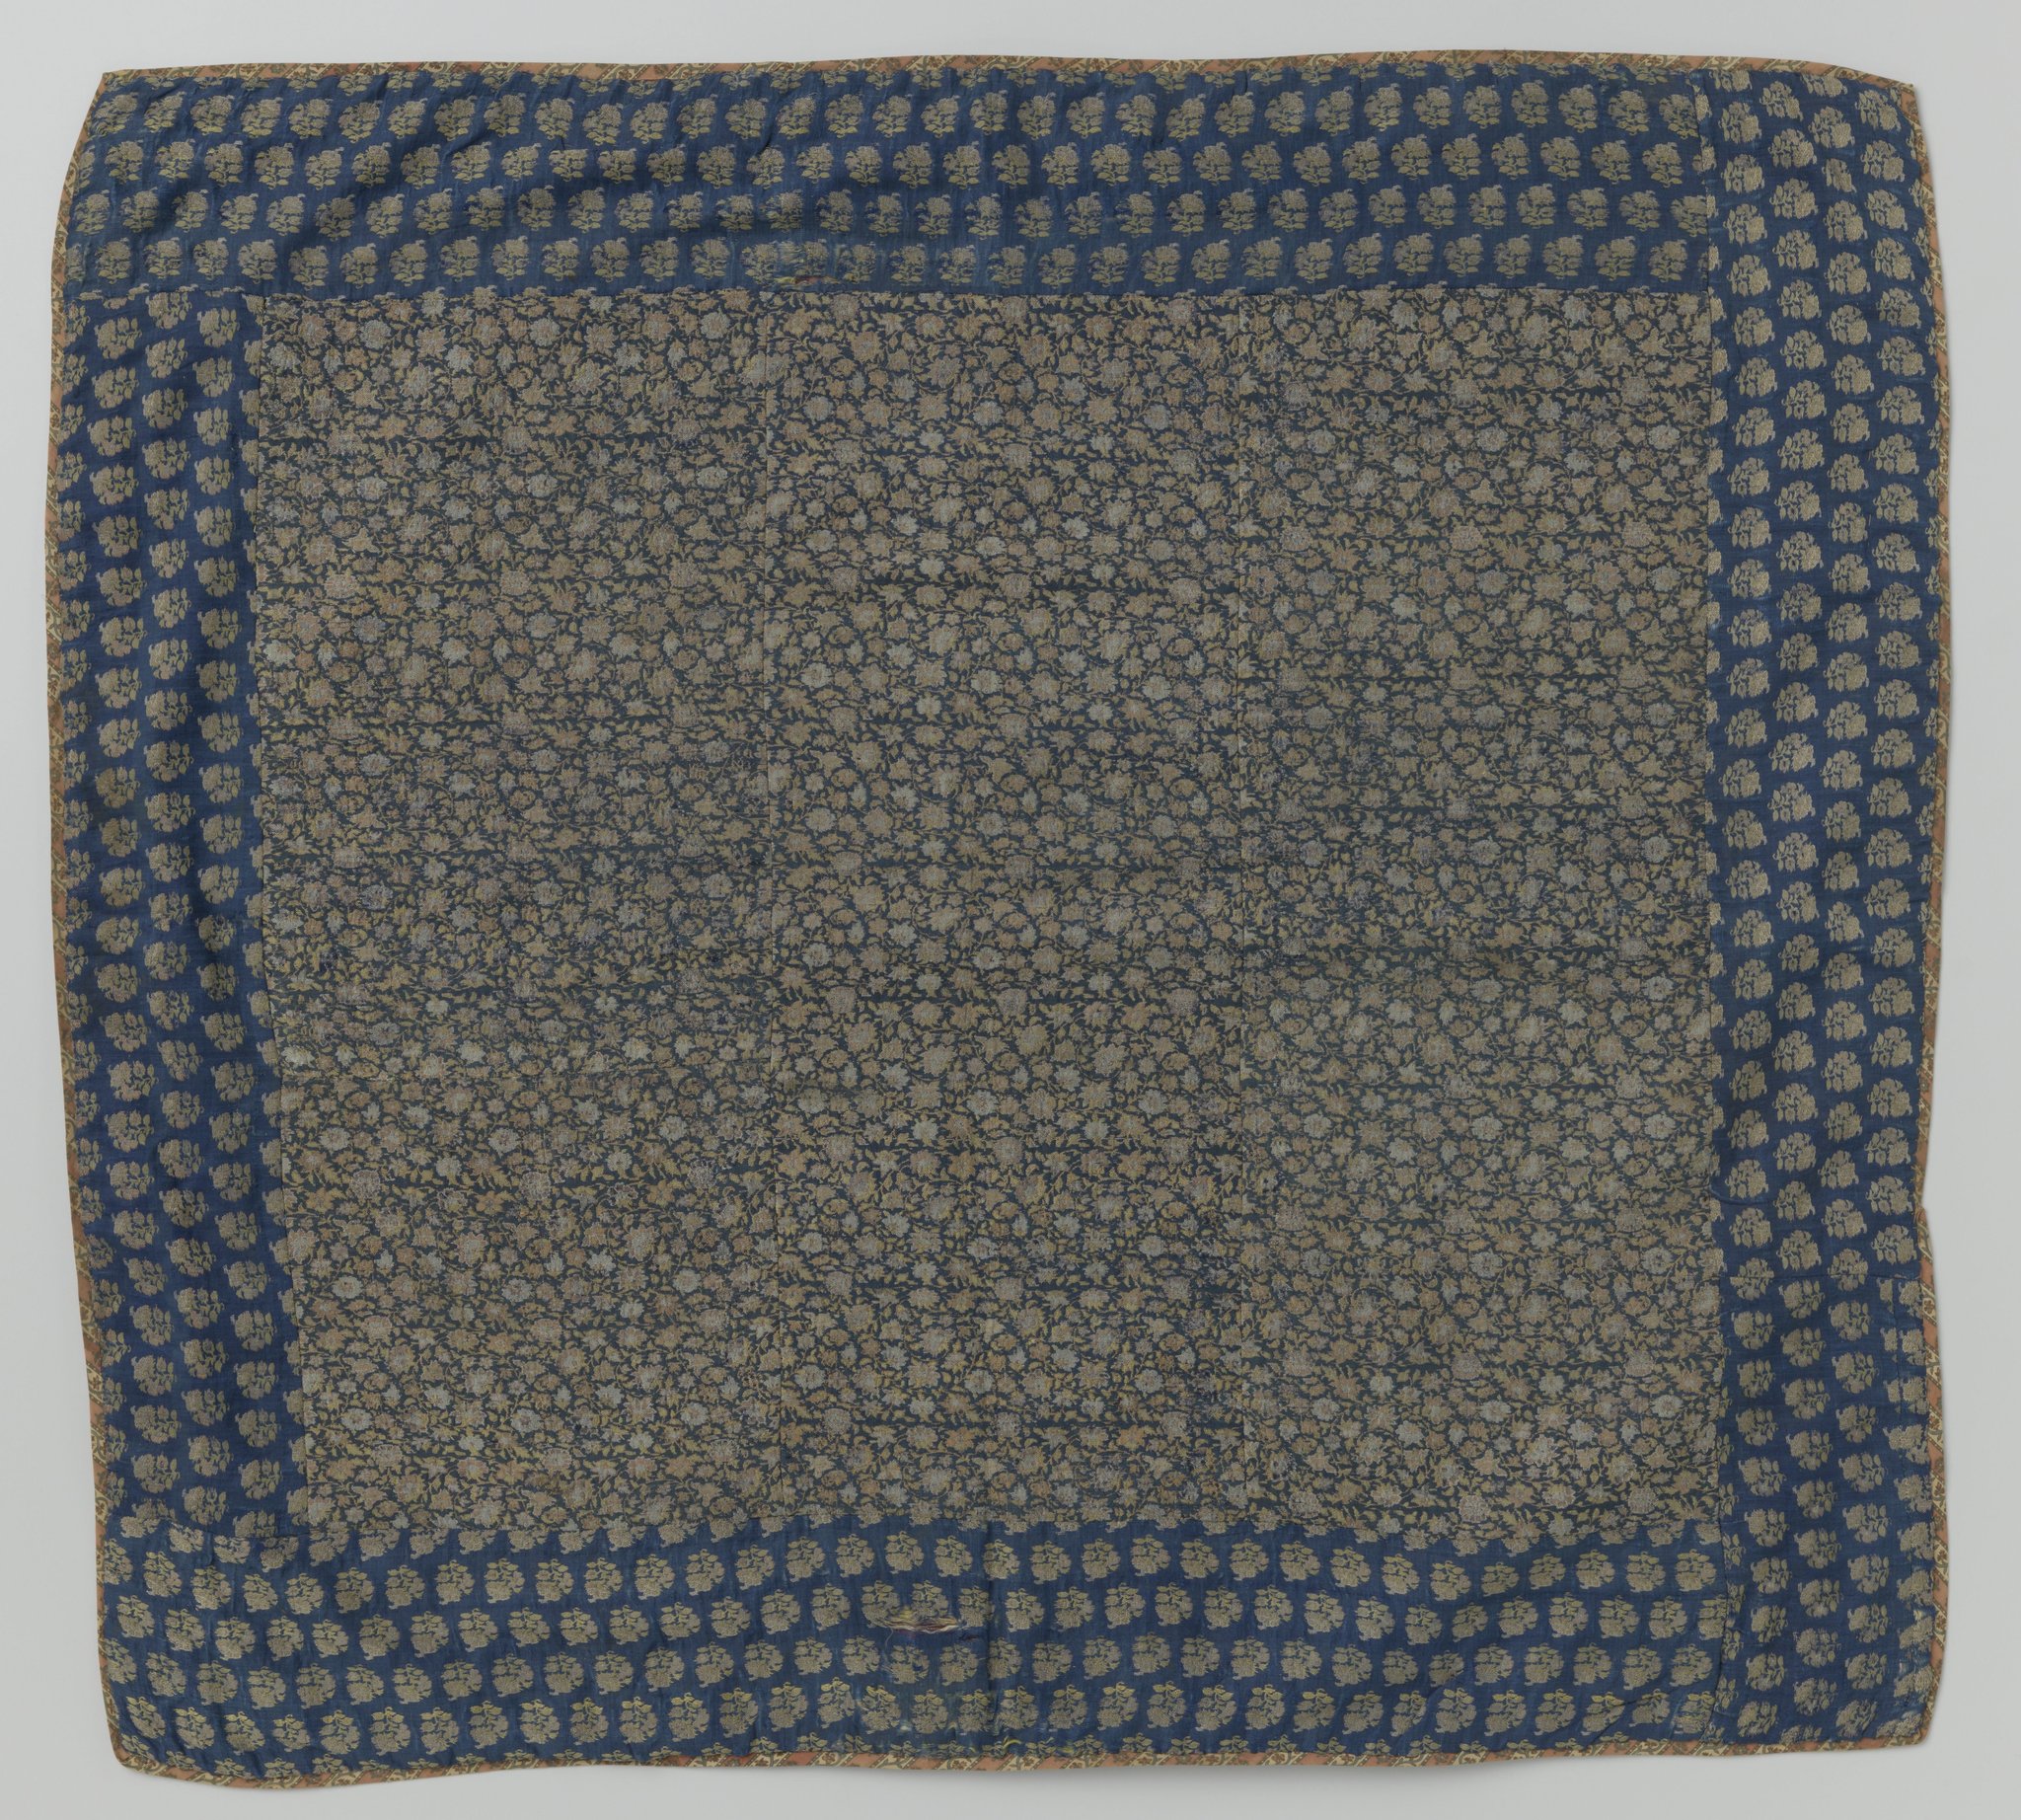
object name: woven material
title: Kleed van zijde met bloemdessin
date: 1770-1850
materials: cotton, silk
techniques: brocade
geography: iran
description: Kleed van zijde met bloemdessin van gebrocheerde zijde met in het centrum een dessin van bloem- en bladranken in roze, geel en grijs op blauw fond; brede rand van idem dessin van boeketten/buta-motief. Gevoerd met changeantzijde in rood/geel en dwars genomen rand van katoen , bedrukt met patroon van strepen met bloemranken. Ingenaaid label met in 19de eeuw (?) handschrift: "Een weefsel met veelkleurige kleine bloemen, afkomstig uit Perzië, no. 5".